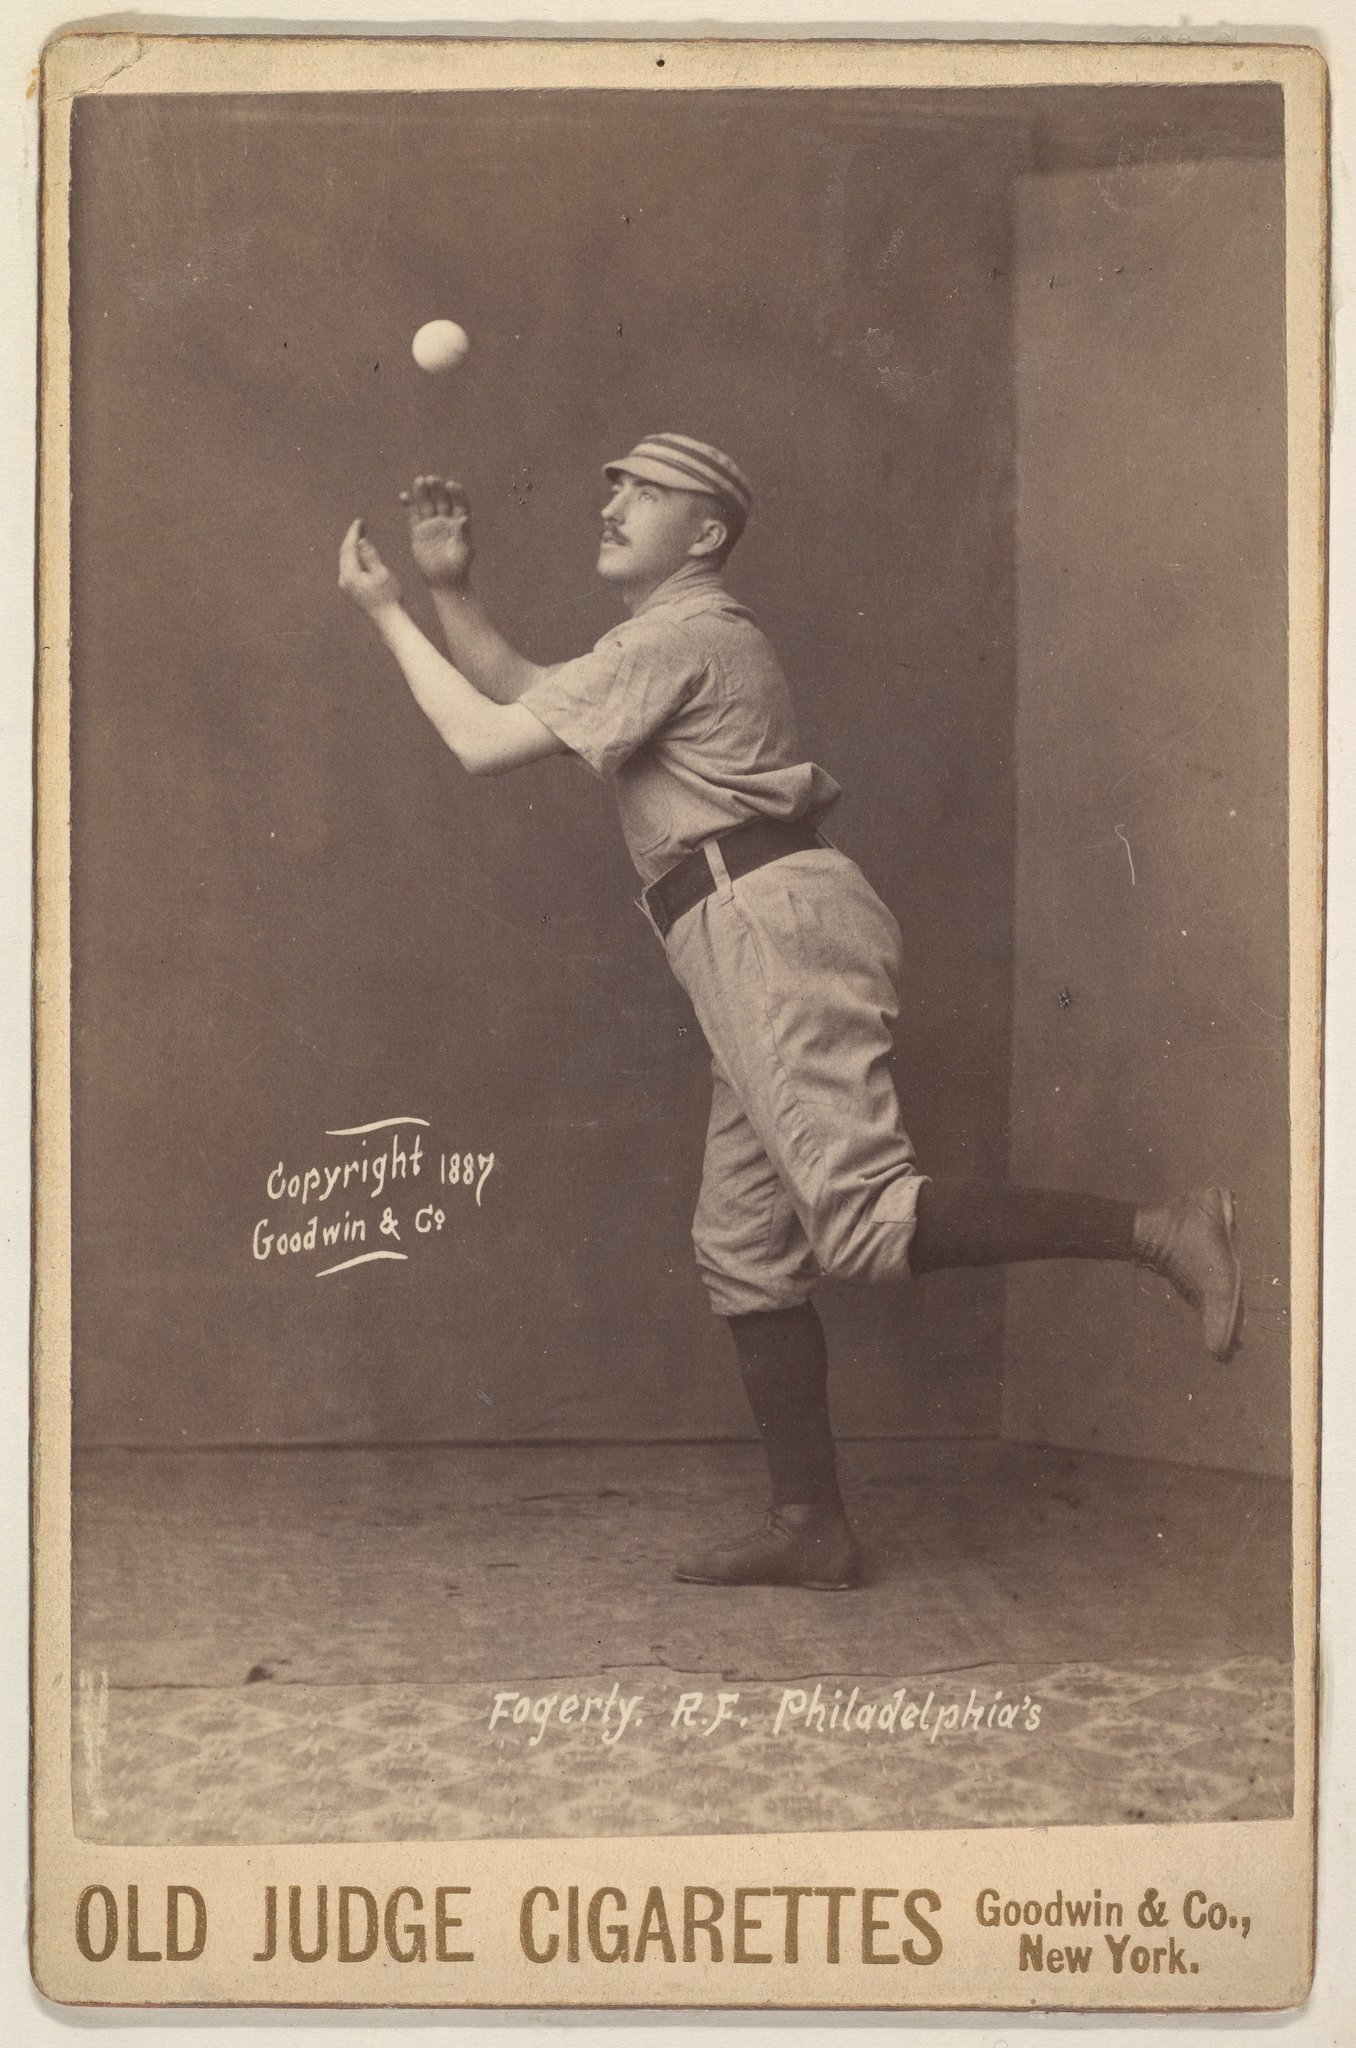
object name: baseball card, photograph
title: Fogerty, Right Field, Philadelphia, from the series Old Judge Cigarettes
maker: goodwin & company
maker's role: publisher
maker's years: 1850-1950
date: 1887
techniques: albumen silver print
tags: men,portraits,baseball,athletes